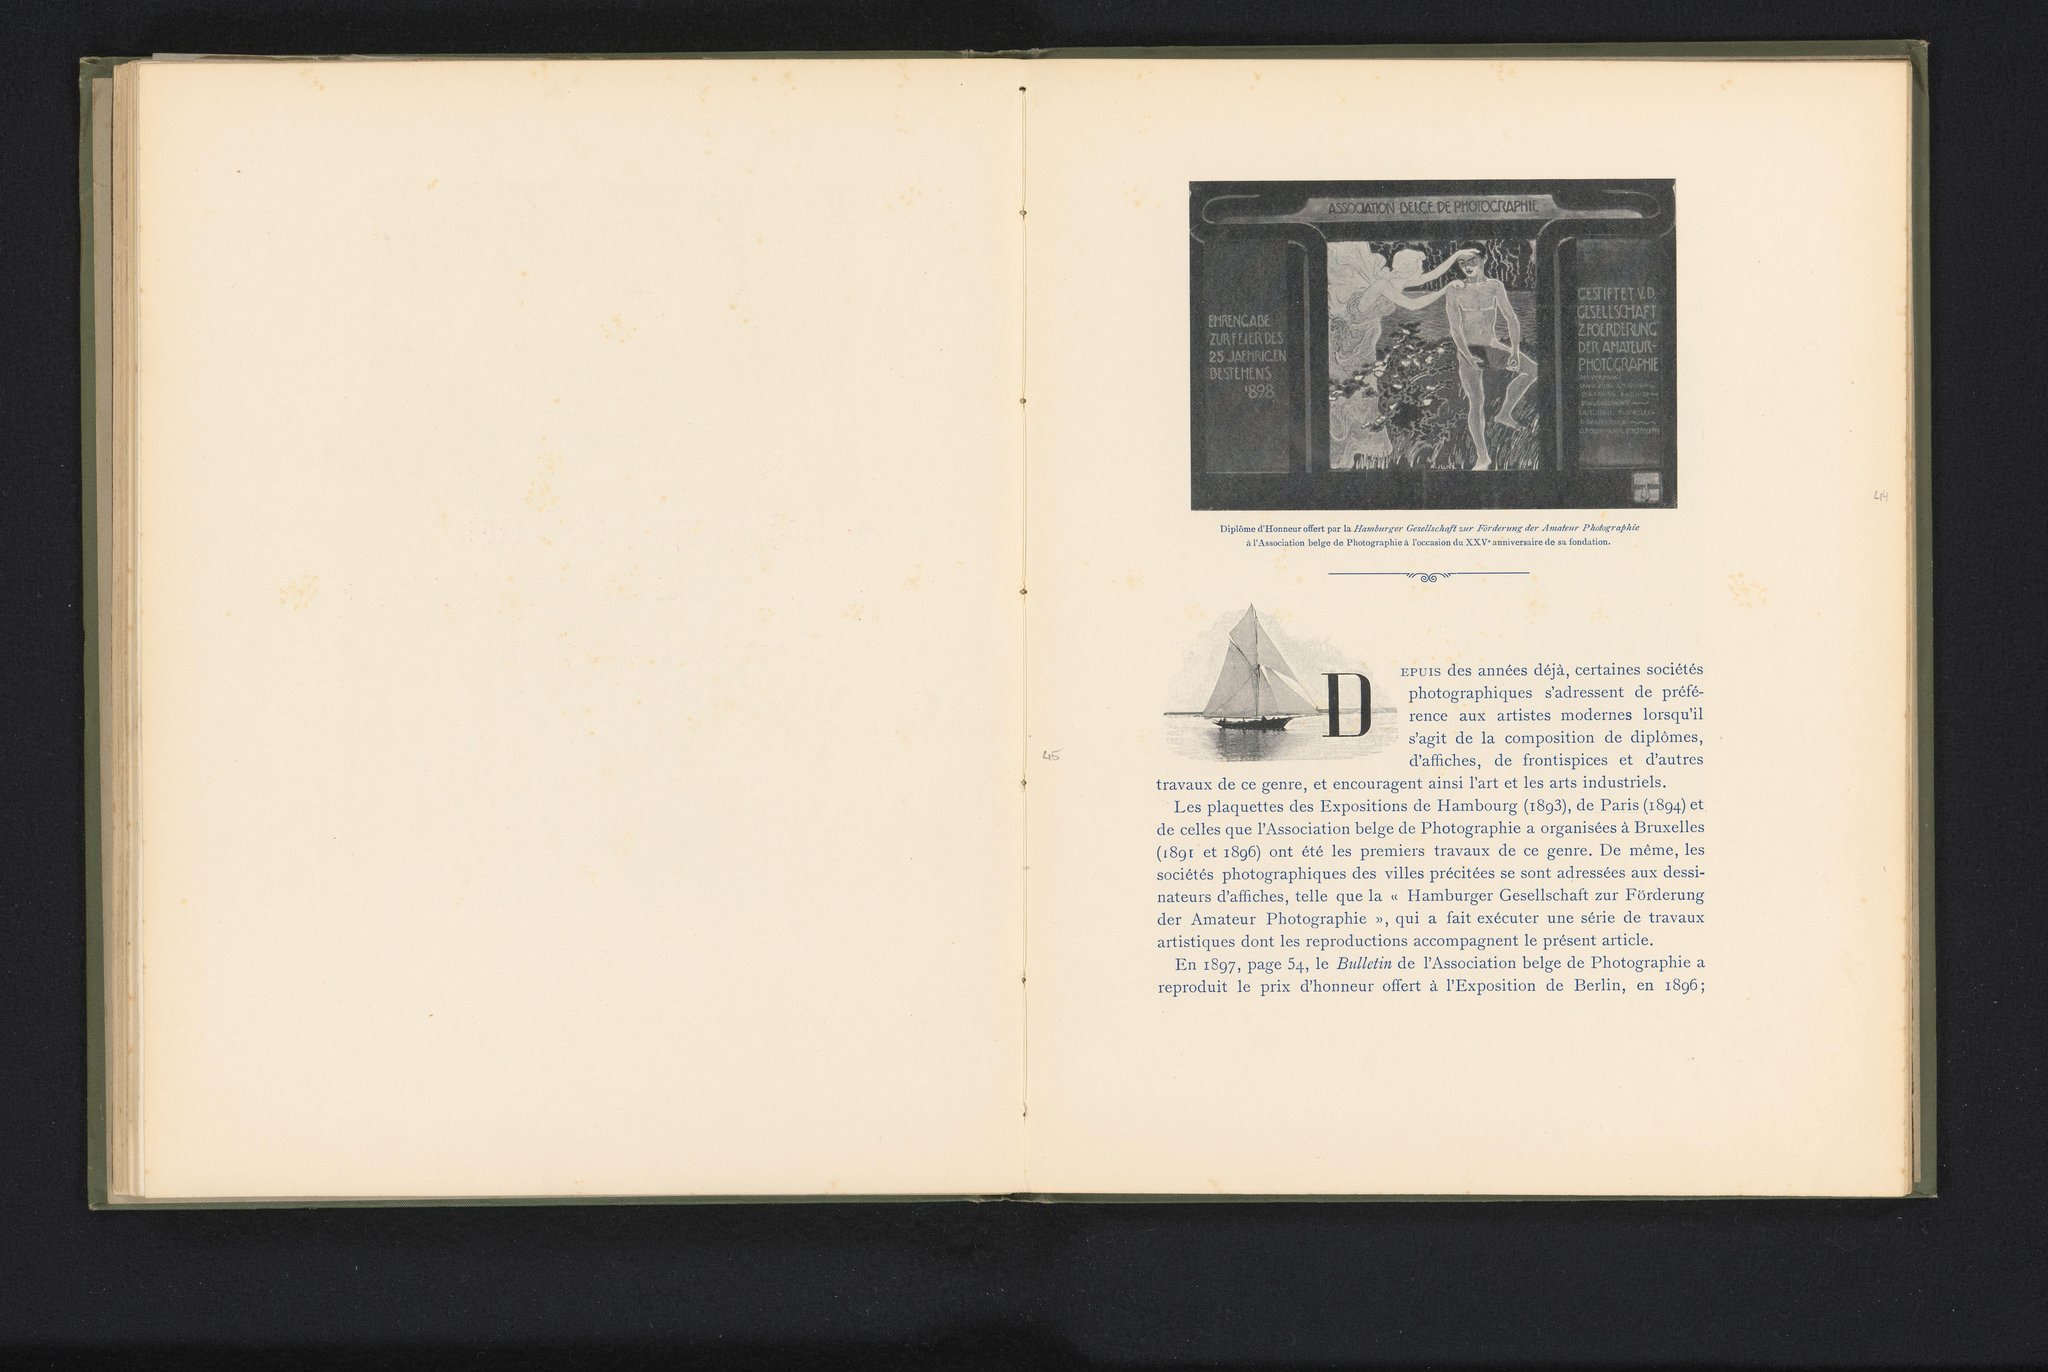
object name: photomechanical print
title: Zeilboot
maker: Anonymous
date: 1893-1898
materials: paper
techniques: autotype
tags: sailing-ship, sailing-boat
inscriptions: inscription: ‘Diplôme d'Honneur offert pa la Hamburger Gesellschaft zur Förderung der Amateur Photographie (...)’